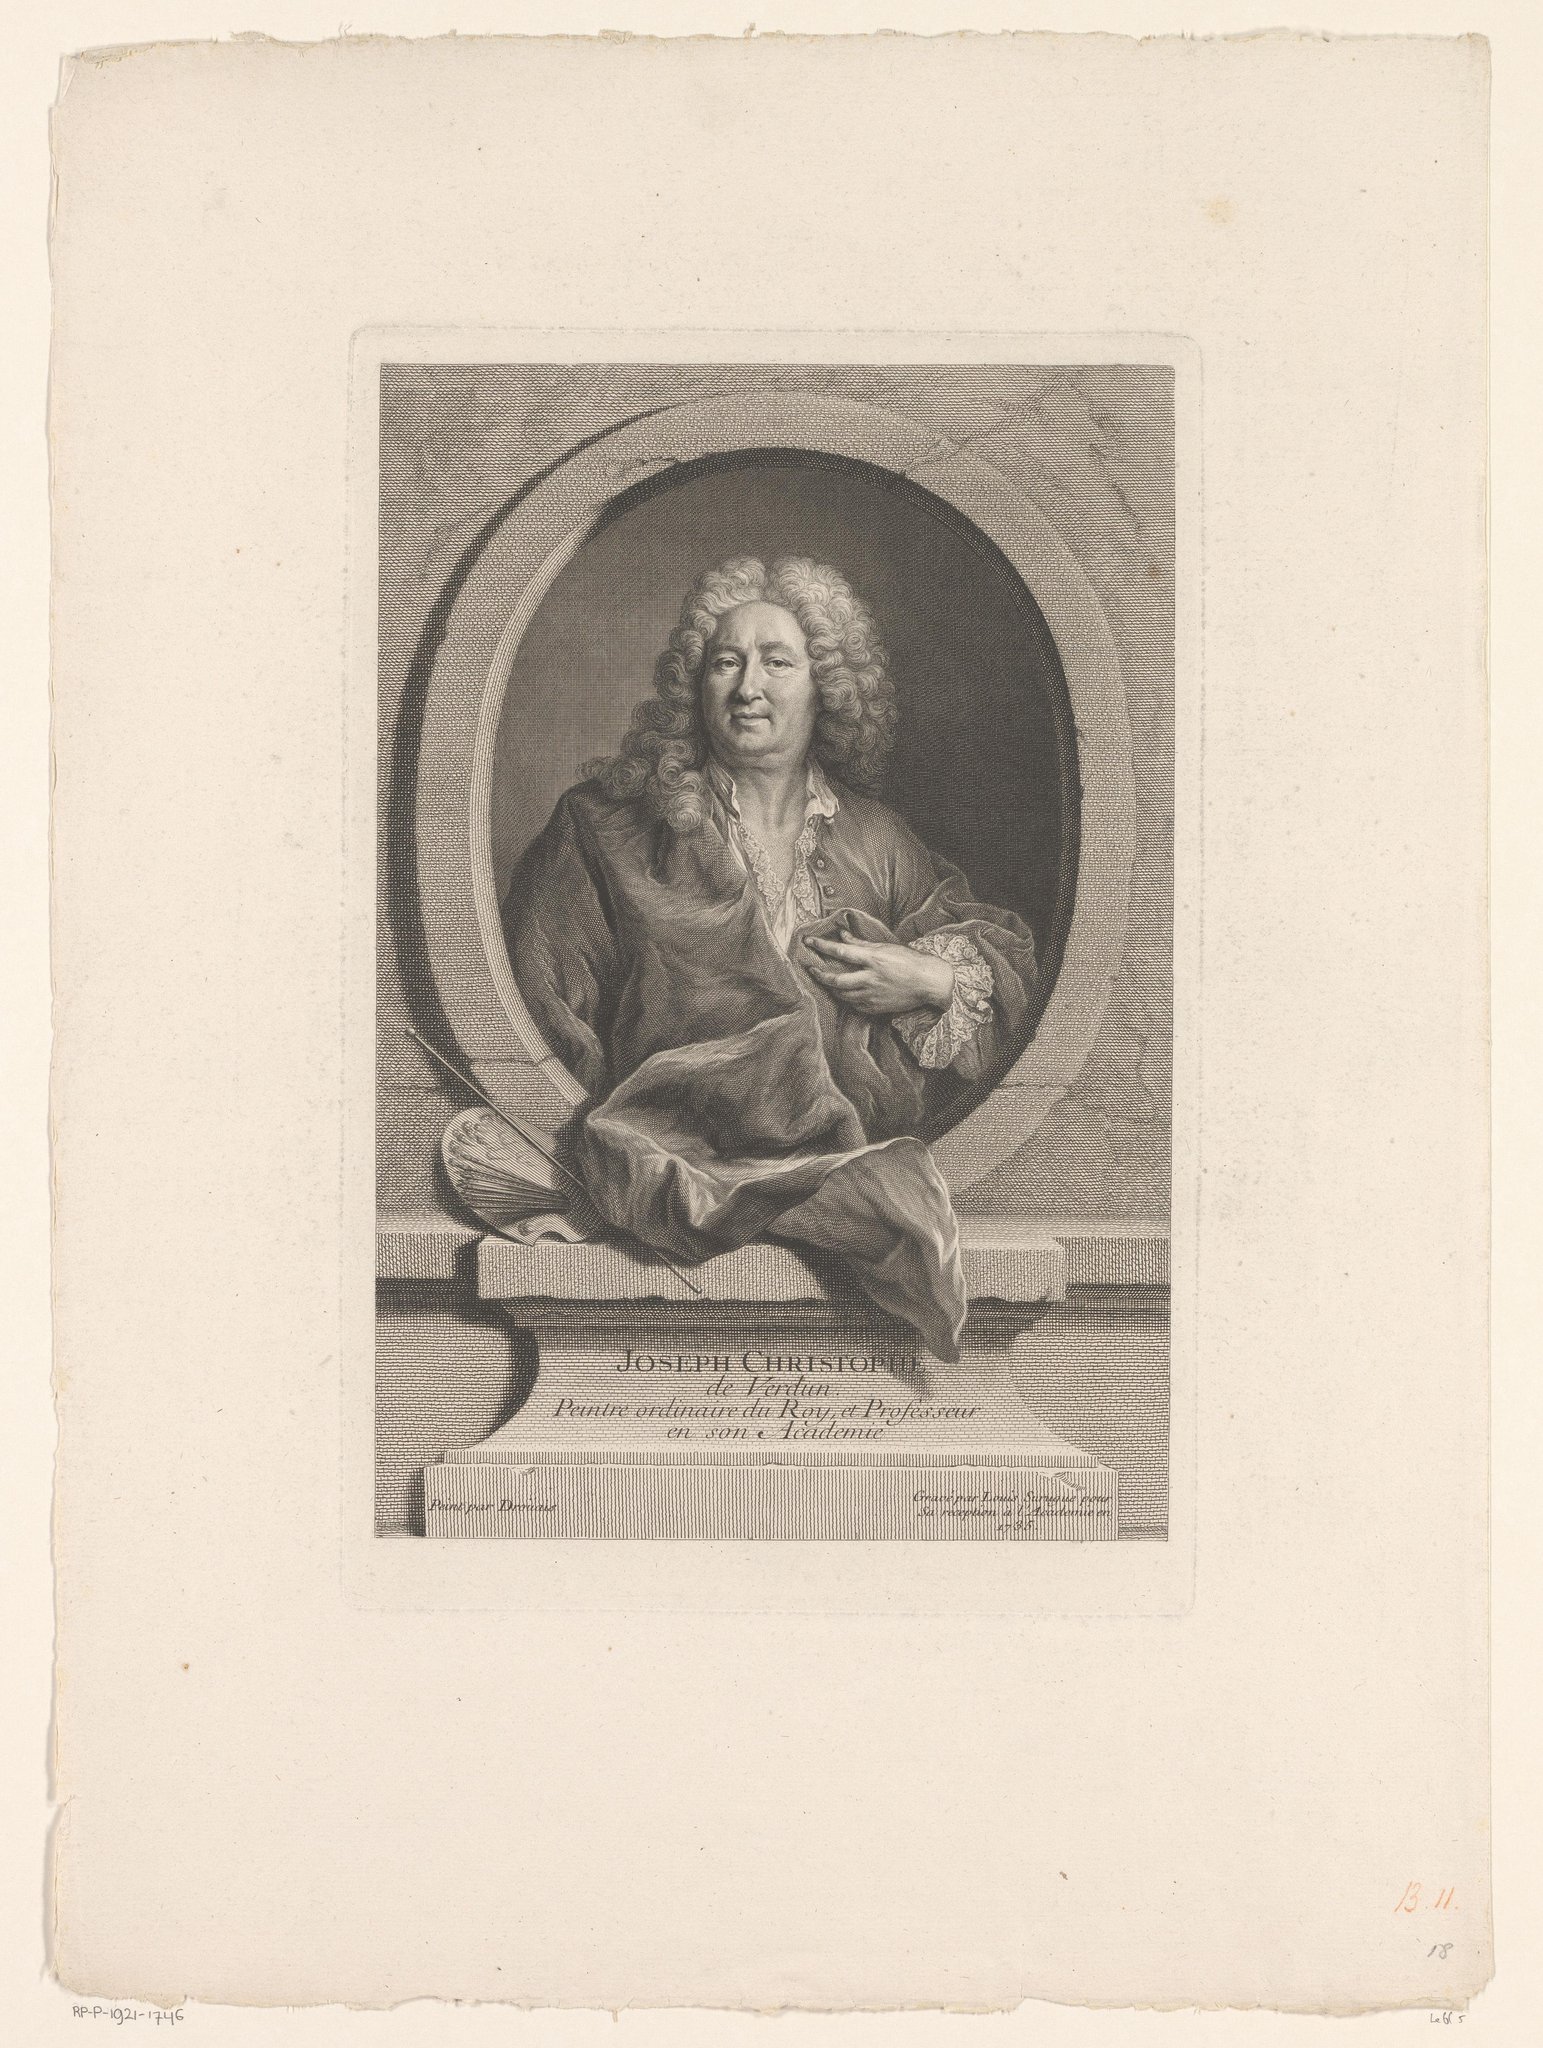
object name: print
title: Joseph Christophe de Verdun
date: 1735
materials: paper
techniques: engraving, etching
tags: paris, painter, historical persons, portrait, self-portrait of painter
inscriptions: collector's mark: Lugt 2233